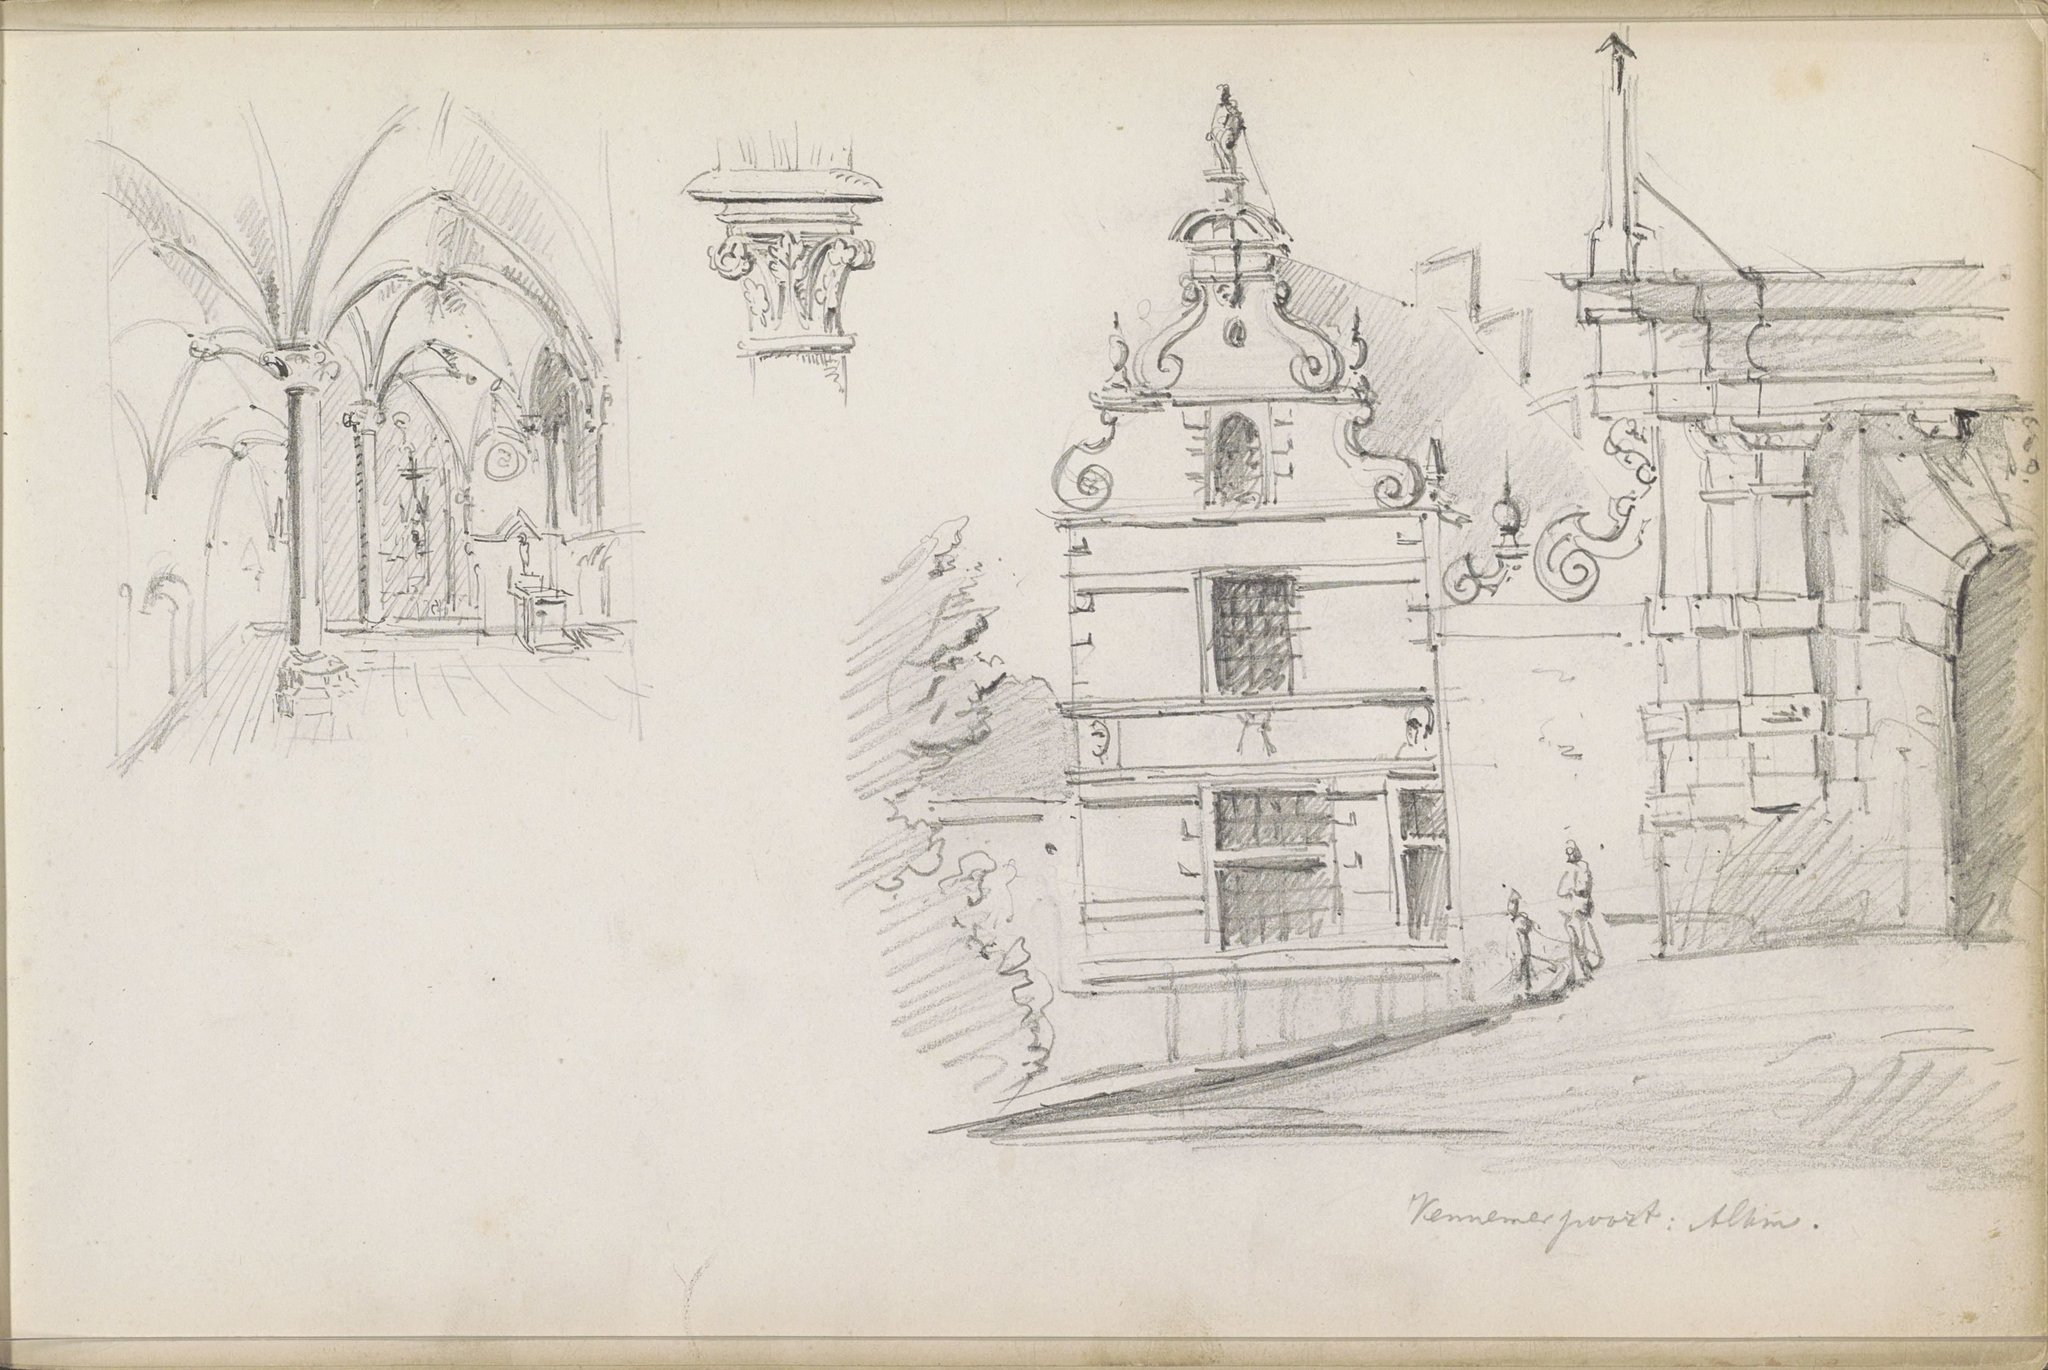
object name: sketchbook leaf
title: Kennemerpoort te Alkmaar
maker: isaac gosschalk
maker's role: draughtsman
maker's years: 1838-1907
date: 1862-1867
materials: paper, pencil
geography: alkmaar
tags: gate, entrance, vault ~ architecture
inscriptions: annotation: ‘Kennemerpoort Alkmaar’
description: Tevens een studie van een interieur overkapt met een kruisribgewelf. Blad 35 recto uit een schetsboek met 58 bladen.